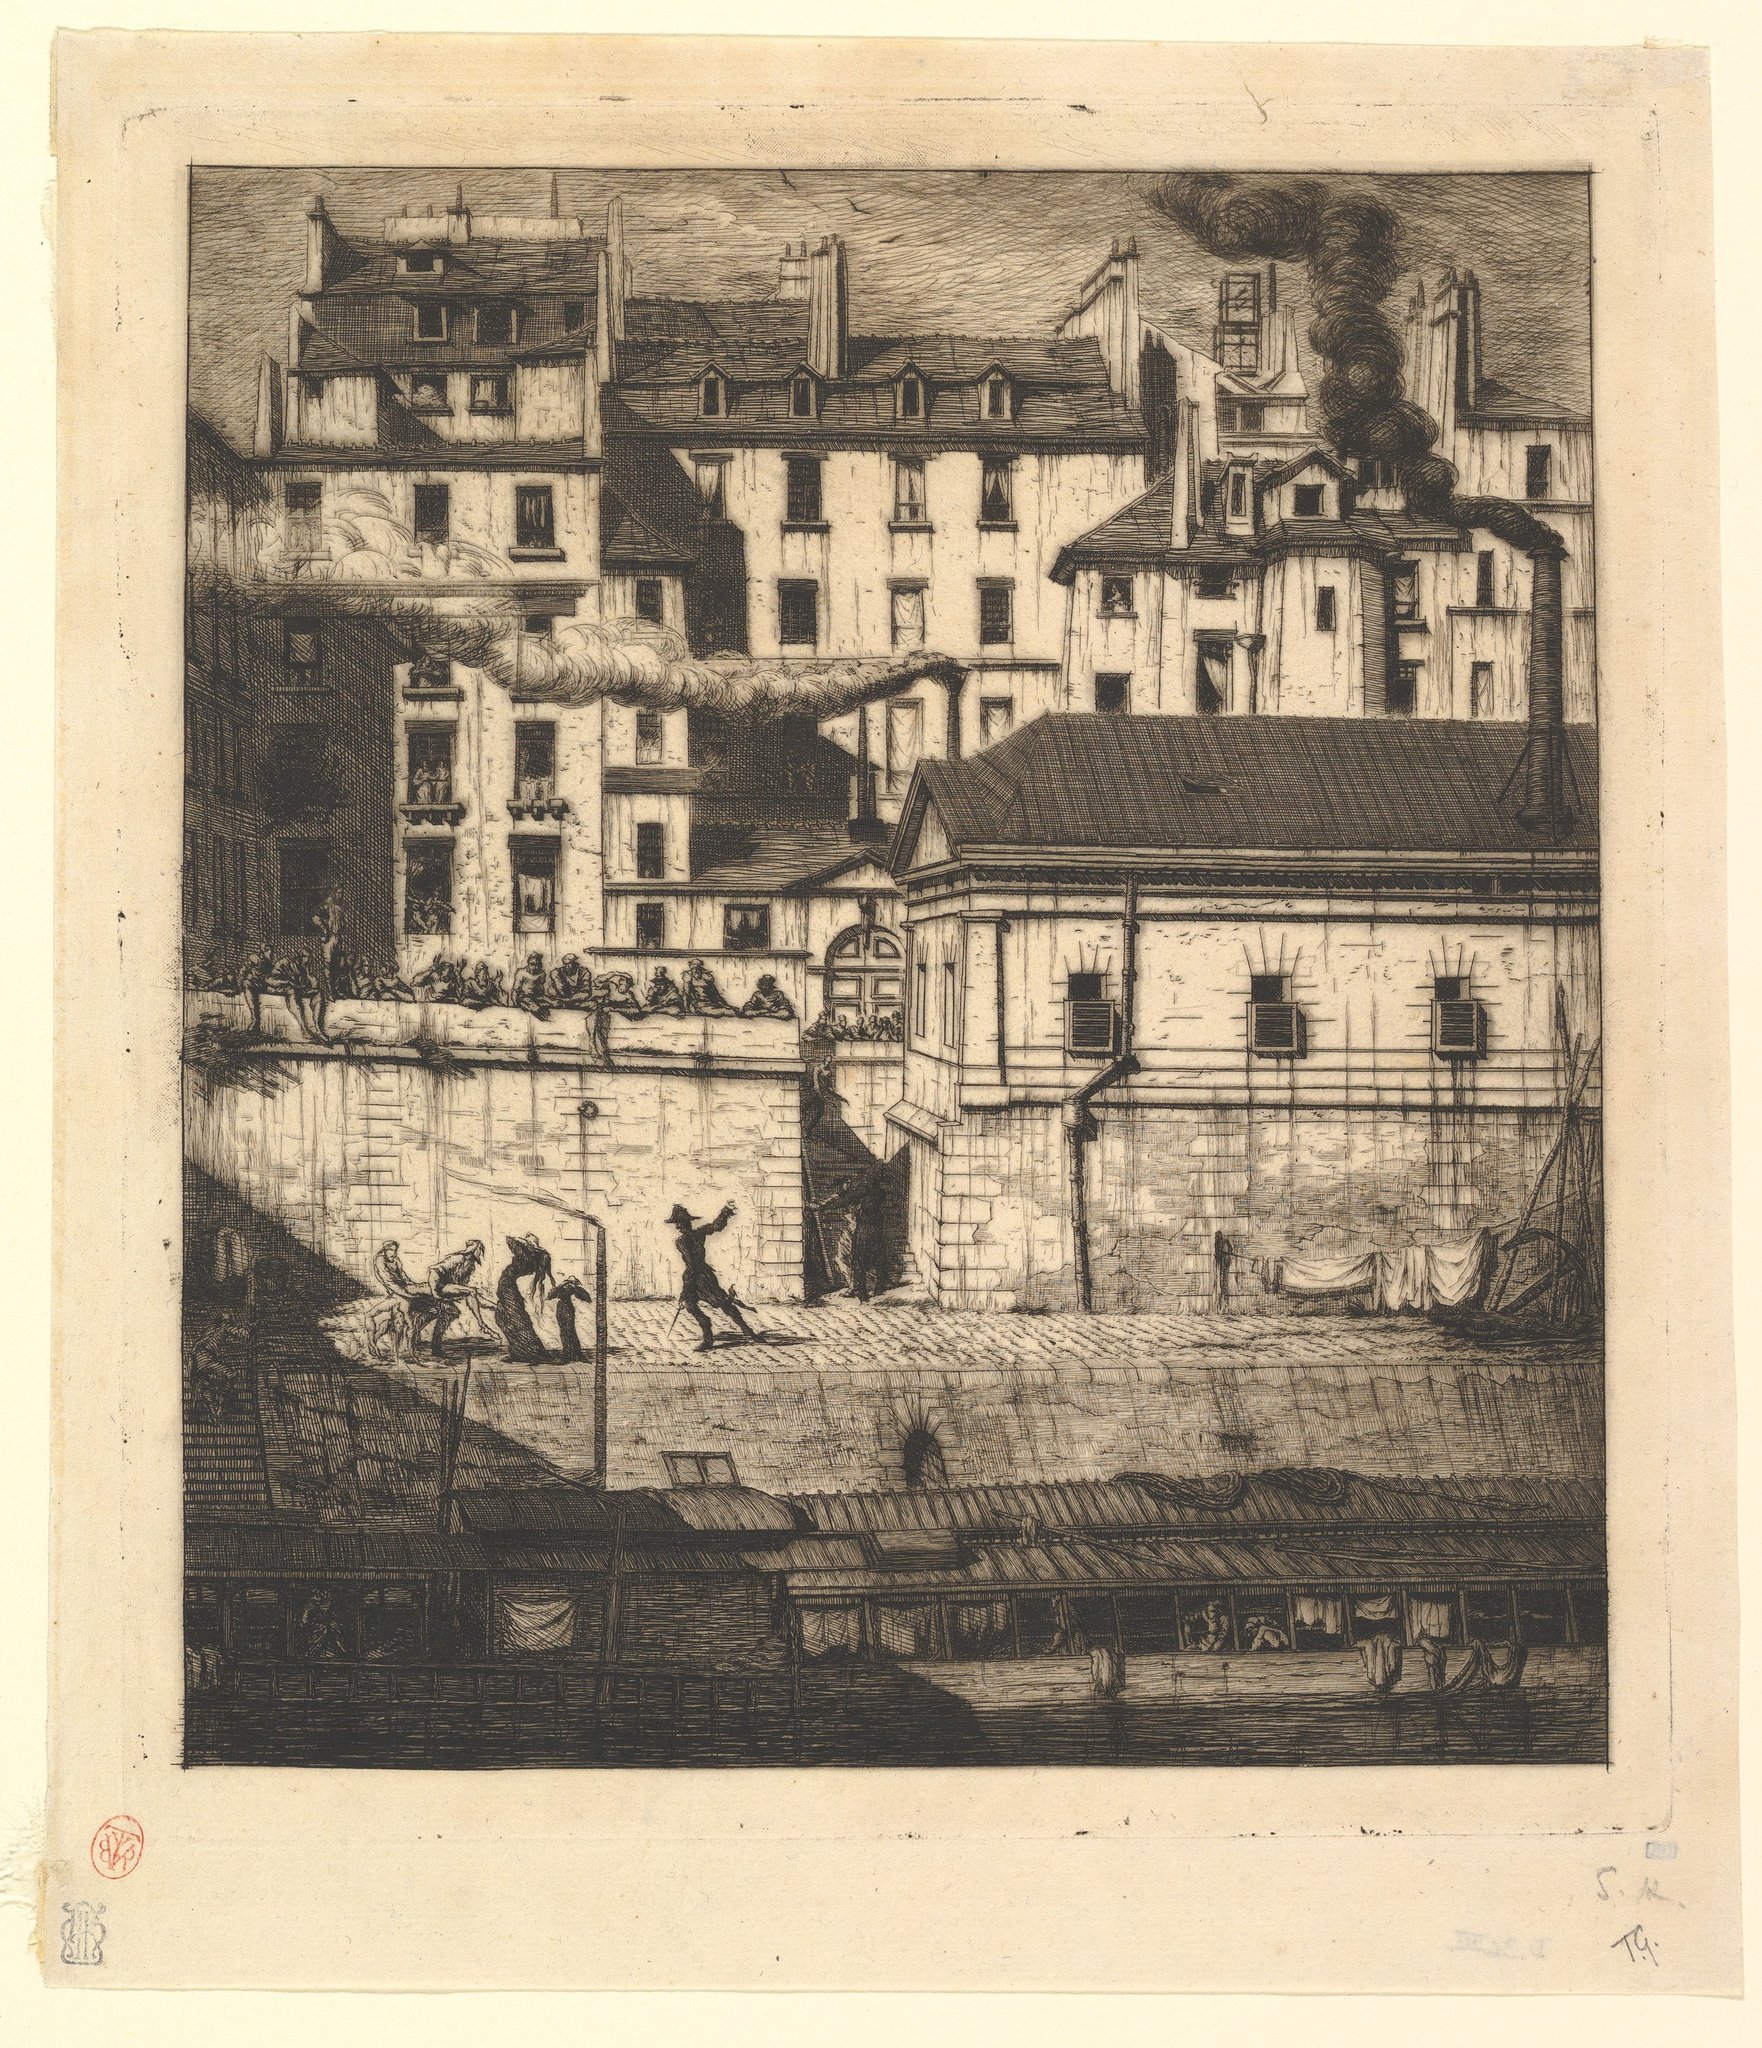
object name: print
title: The Mortuary, Paris (La Morgue)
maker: charles meryon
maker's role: artist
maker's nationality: french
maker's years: 1821-1868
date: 1854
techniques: drypoint, etching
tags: buildings,paris